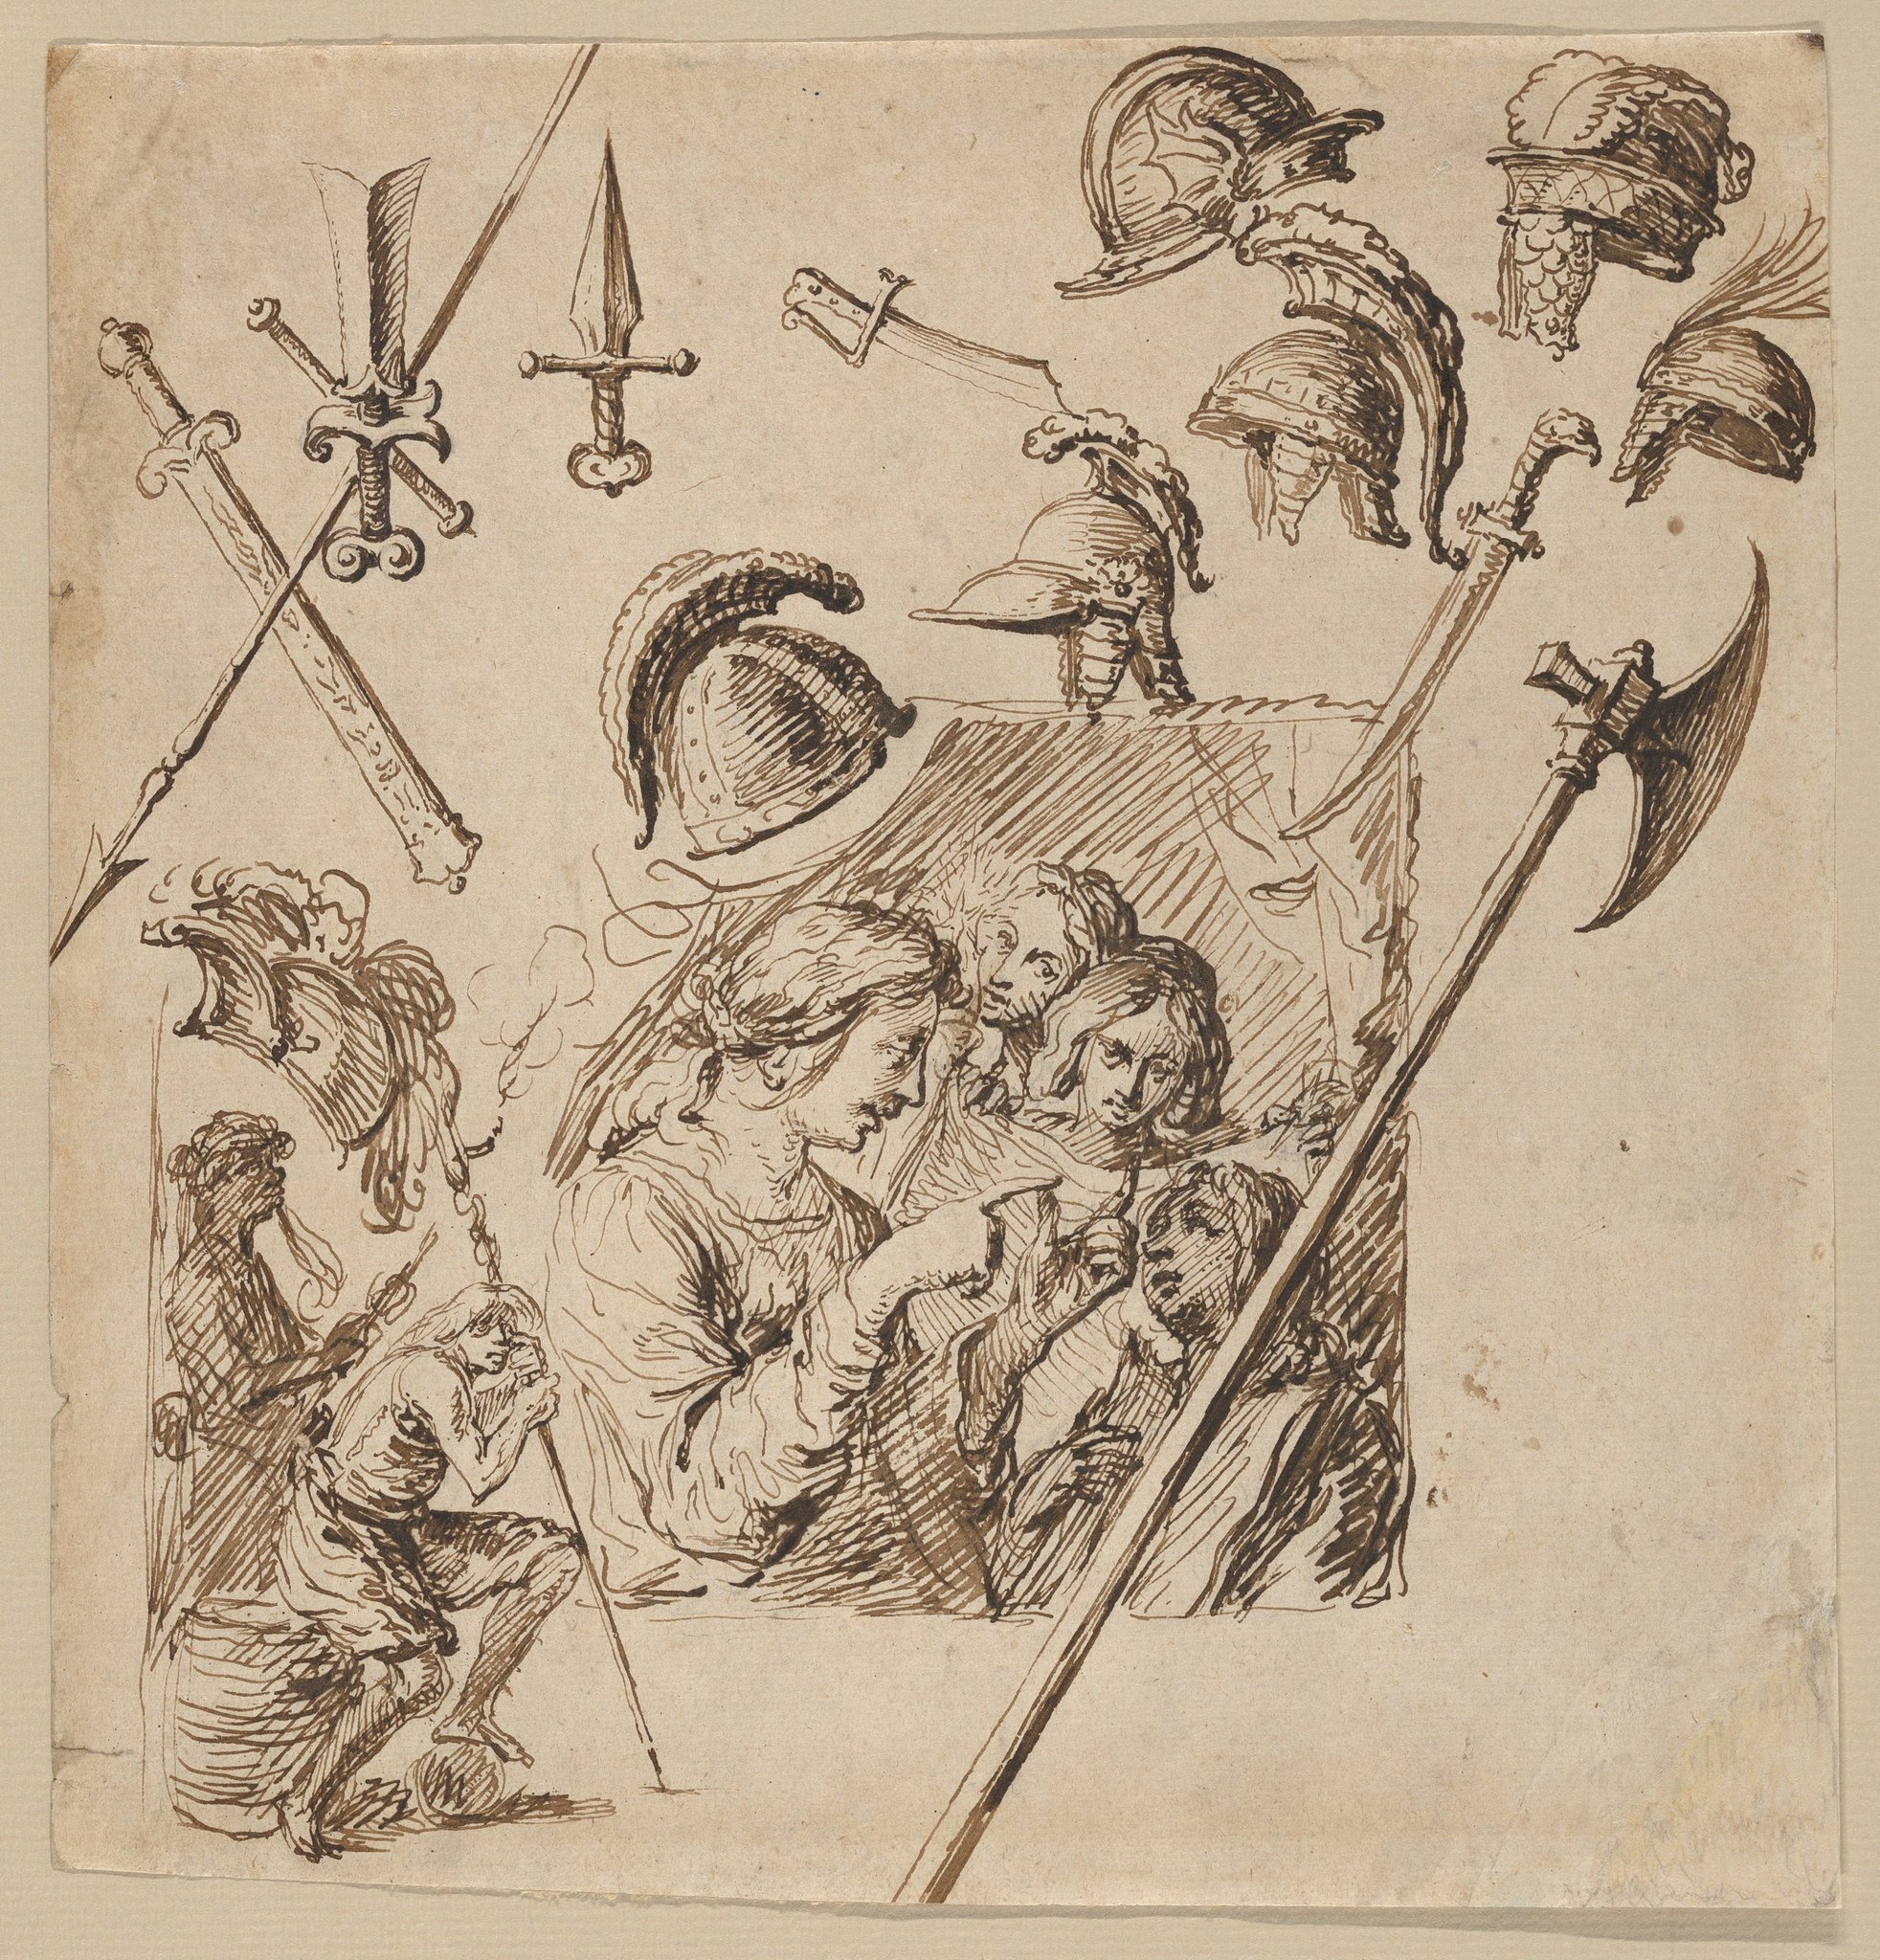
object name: drawing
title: Sheet with Two Figural Compositions and Studies of Helmets and Arms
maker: jacques de gheyn (ii)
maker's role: artist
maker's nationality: netherlandish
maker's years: 1565-1629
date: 1620-1629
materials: chalk, ink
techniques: pen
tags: helmets,weapons,men,women